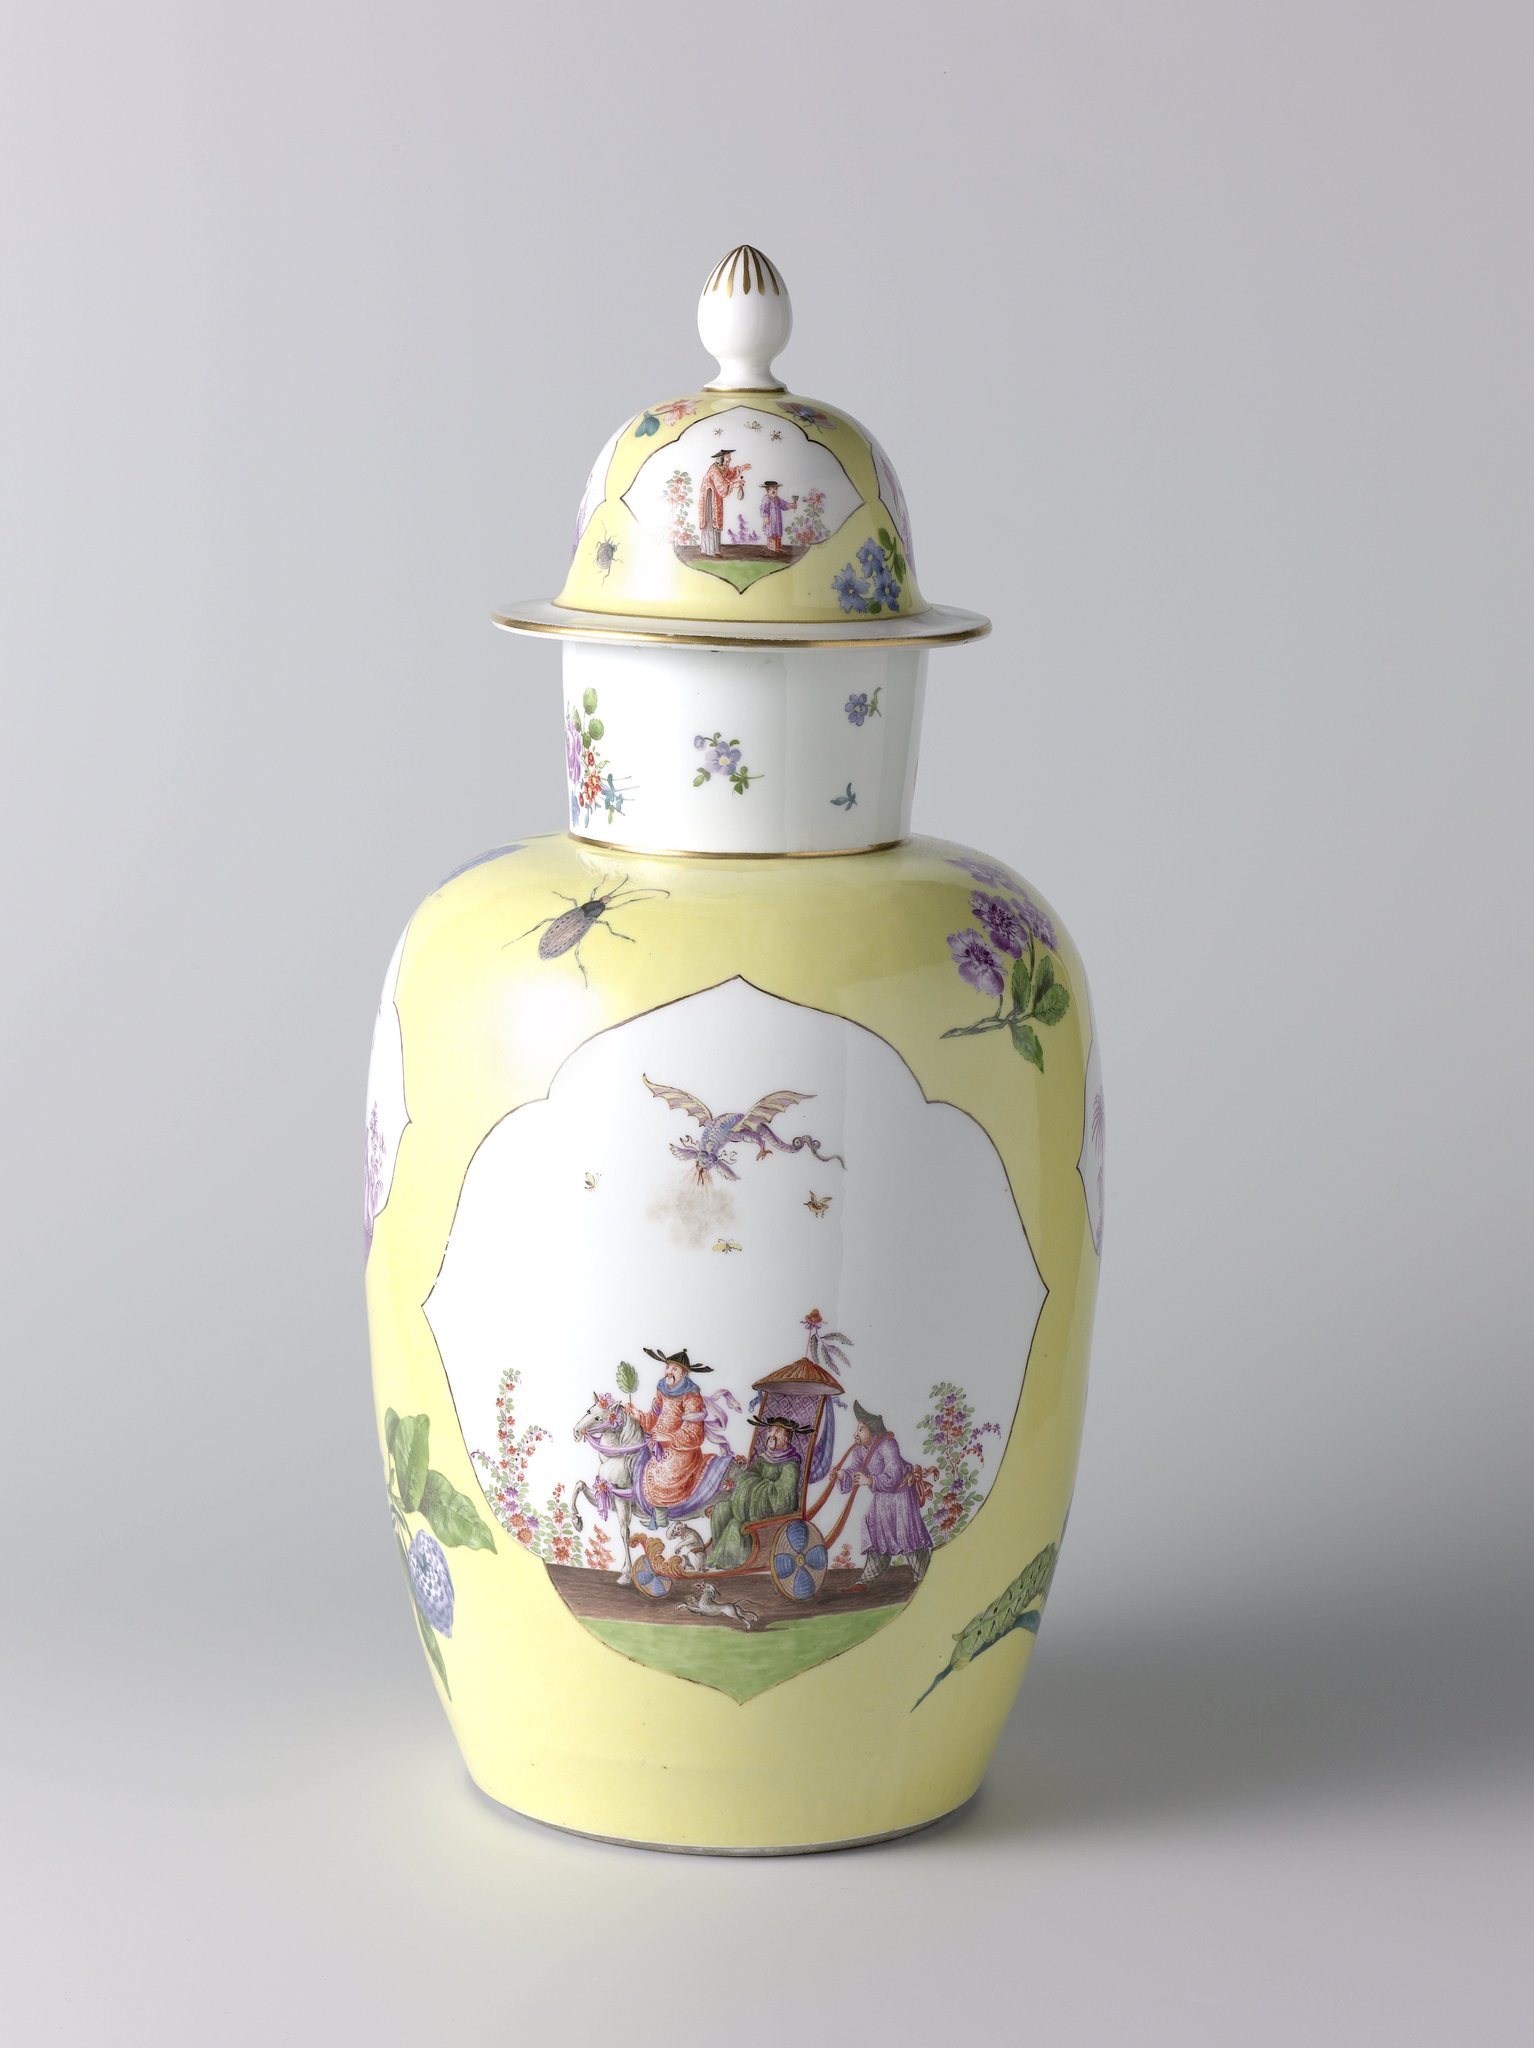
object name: decoratief object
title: Lidded vase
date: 1740-1745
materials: porcelain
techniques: painted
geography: meissen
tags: flowers, chinese (+ other cultural aspects), insects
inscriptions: factory mark: ‘AR’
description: Vaas van beschilderd porselein. De vaas is bijna geheel bedekt met een gele fond waarin uitgespaard twee grote en twee kleine en op het deksel vier kleine vierpassen waarbinnen Höroldt-chinoiserieën. Tussen de uitgespaarde velden zijn bloemtakken en insekten geschilderd. Binnen een grote vierpas zijn vier figuren bij een hek geschilderd en binnen de ander een ruiter en een in een wagen voortgeduwde man. De vaas is gemerkt.